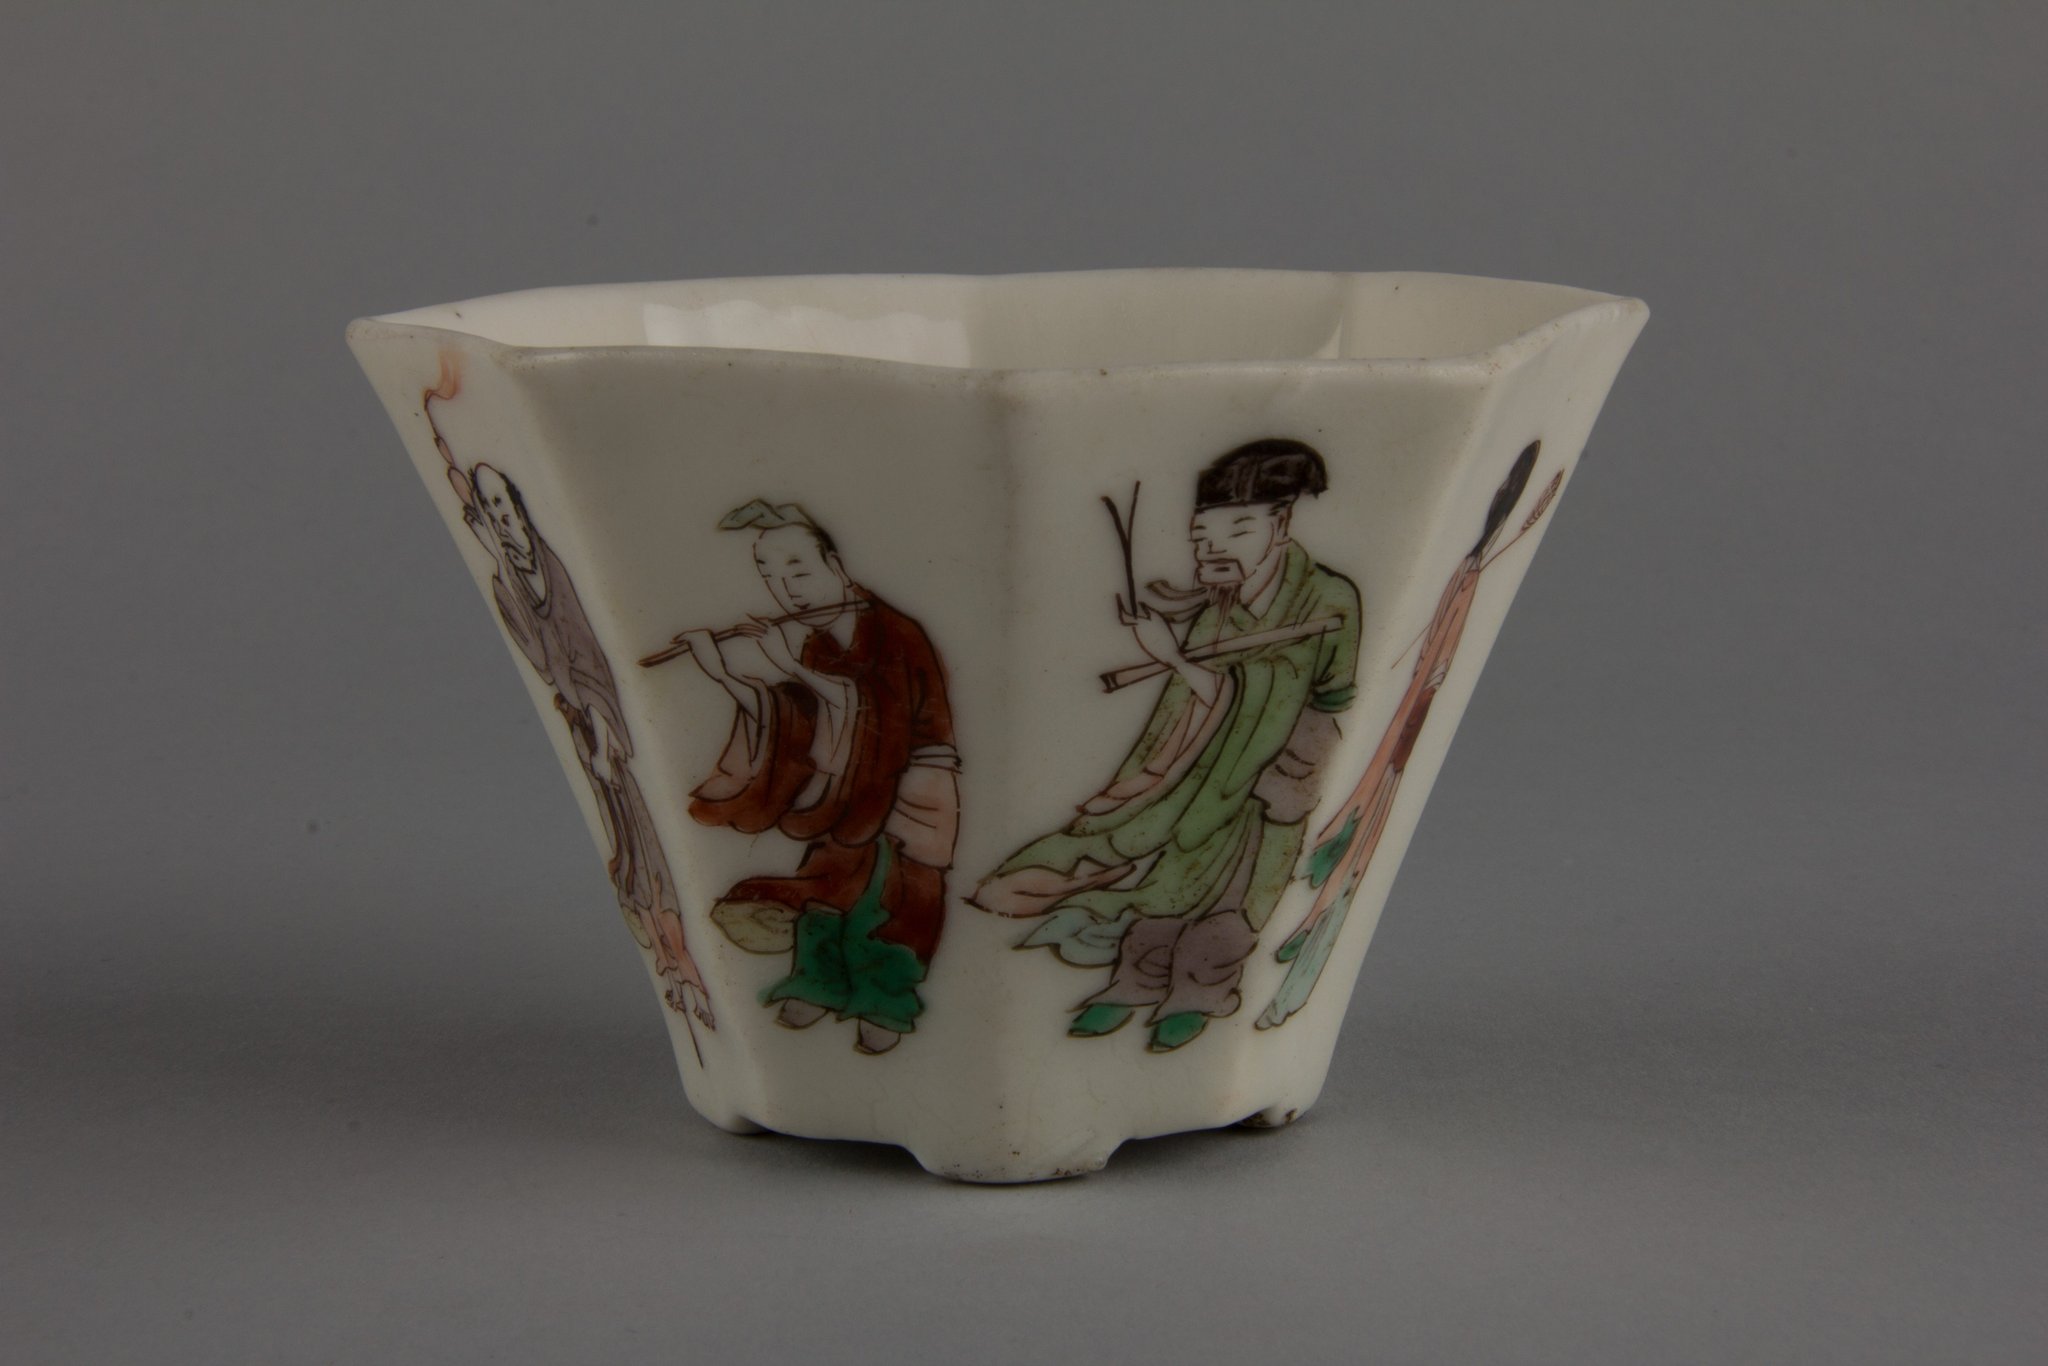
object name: cup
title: Octagonal cup with the Eight Immortals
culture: chinese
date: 1601-1700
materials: enamel, porcelain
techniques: overglaze, painting, polychrome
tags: men,music,flutes